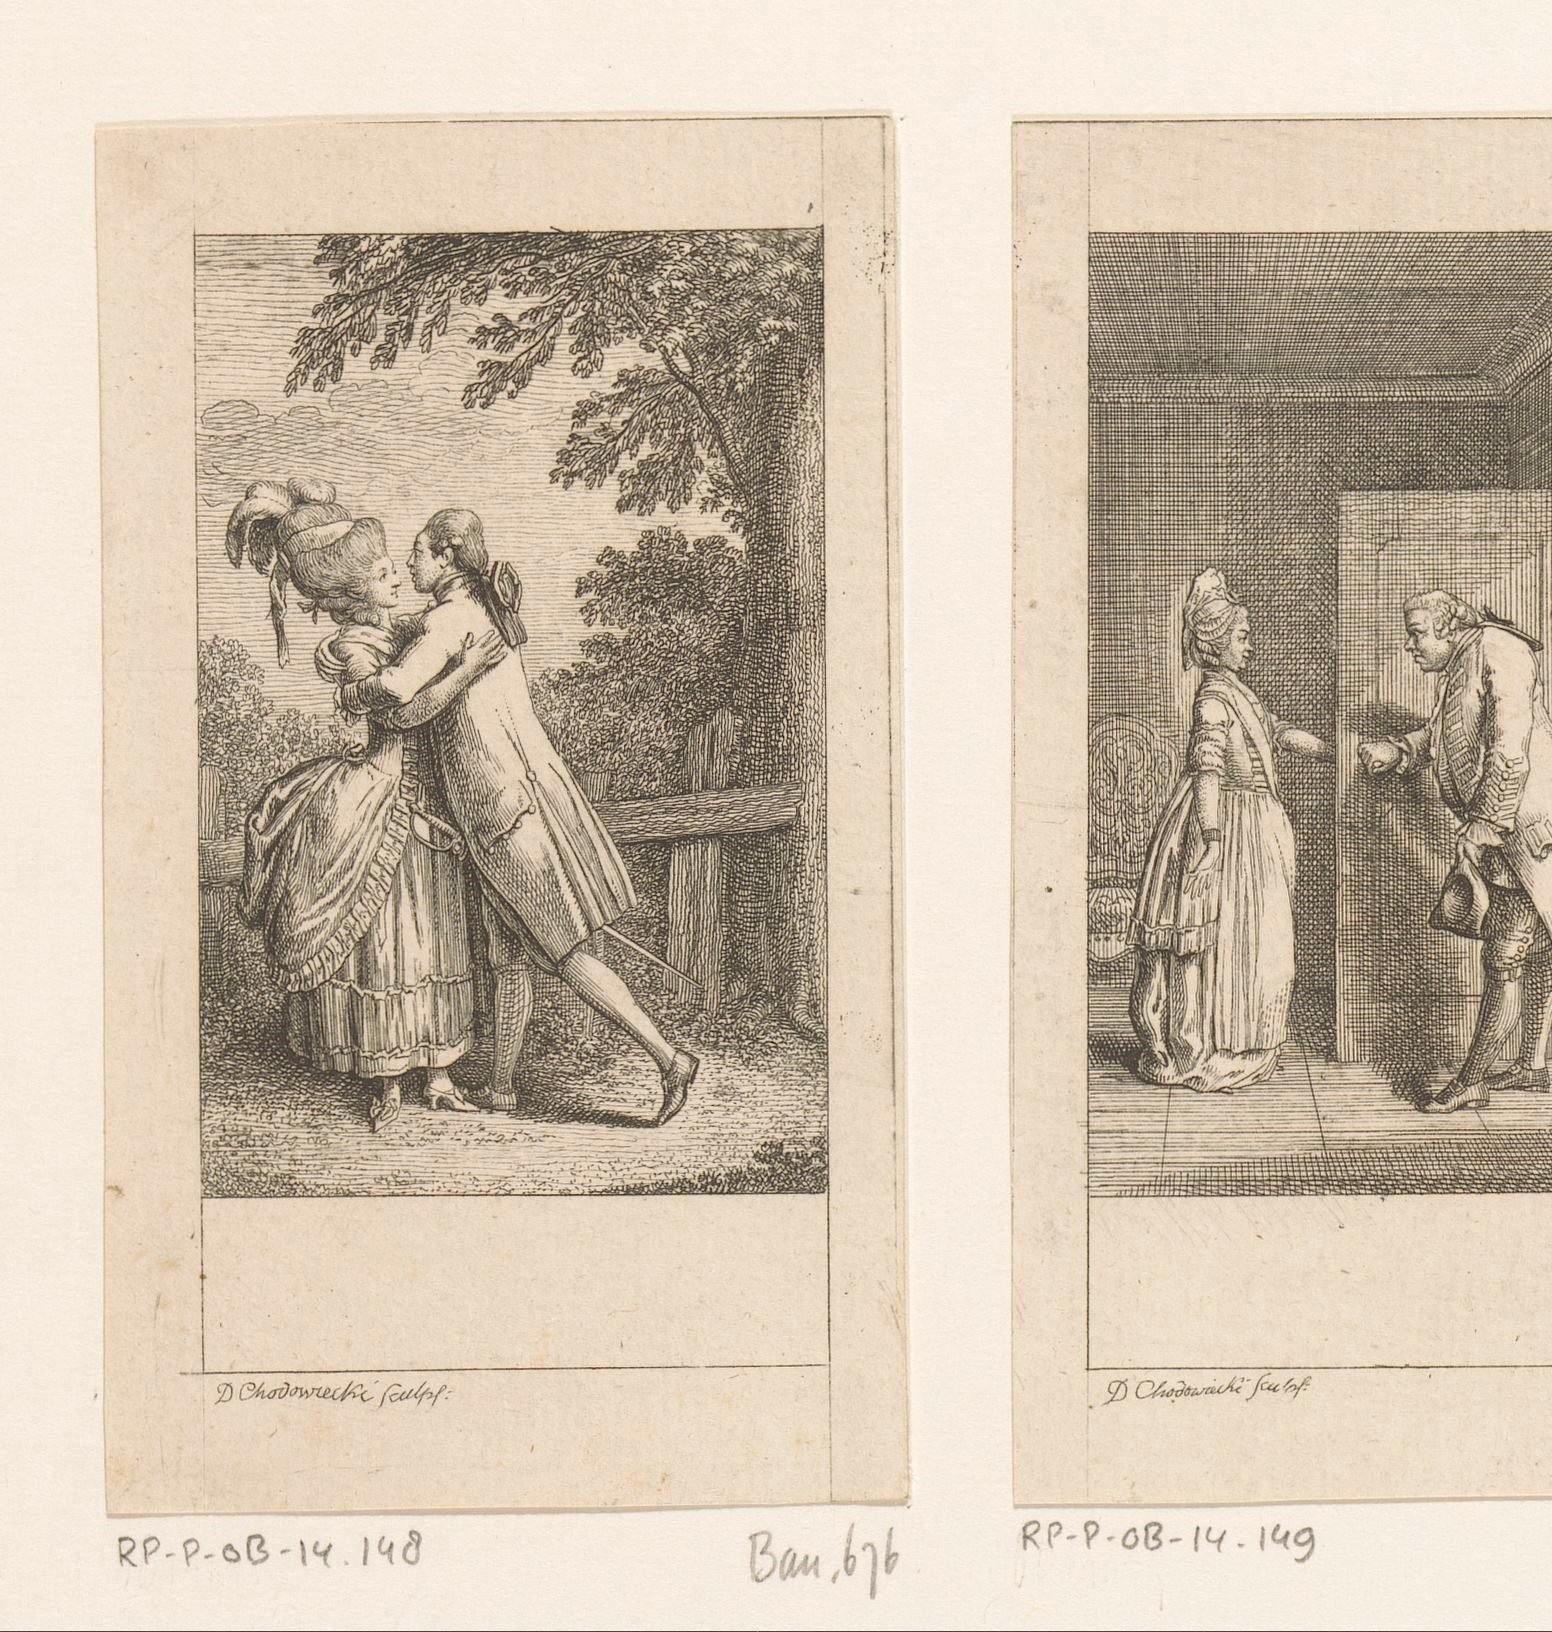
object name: print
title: Jong stel omhelst elkaar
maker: daniel nikolaus chodowiecki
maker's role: draughtsman, print maker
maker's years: 1726-1801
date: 1779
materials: paper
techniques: etching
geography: berlin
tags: literature, embracing each other, kissing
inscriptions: collector's mark: Lugt 2228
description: Eerste prent uit een serie van twaalf prenten die de 'Fabeln und Erzählungen' van Gotthold Ephraim Lessing illustreren. De scènes werden op een plaat geëtst. Een latere staat van deze serie is ook gebruikt in: Almanac de Gotha contenant diverses connoissances curieuses et utiles pour l'annee 1780. Gotha, C.W. Ettinger.